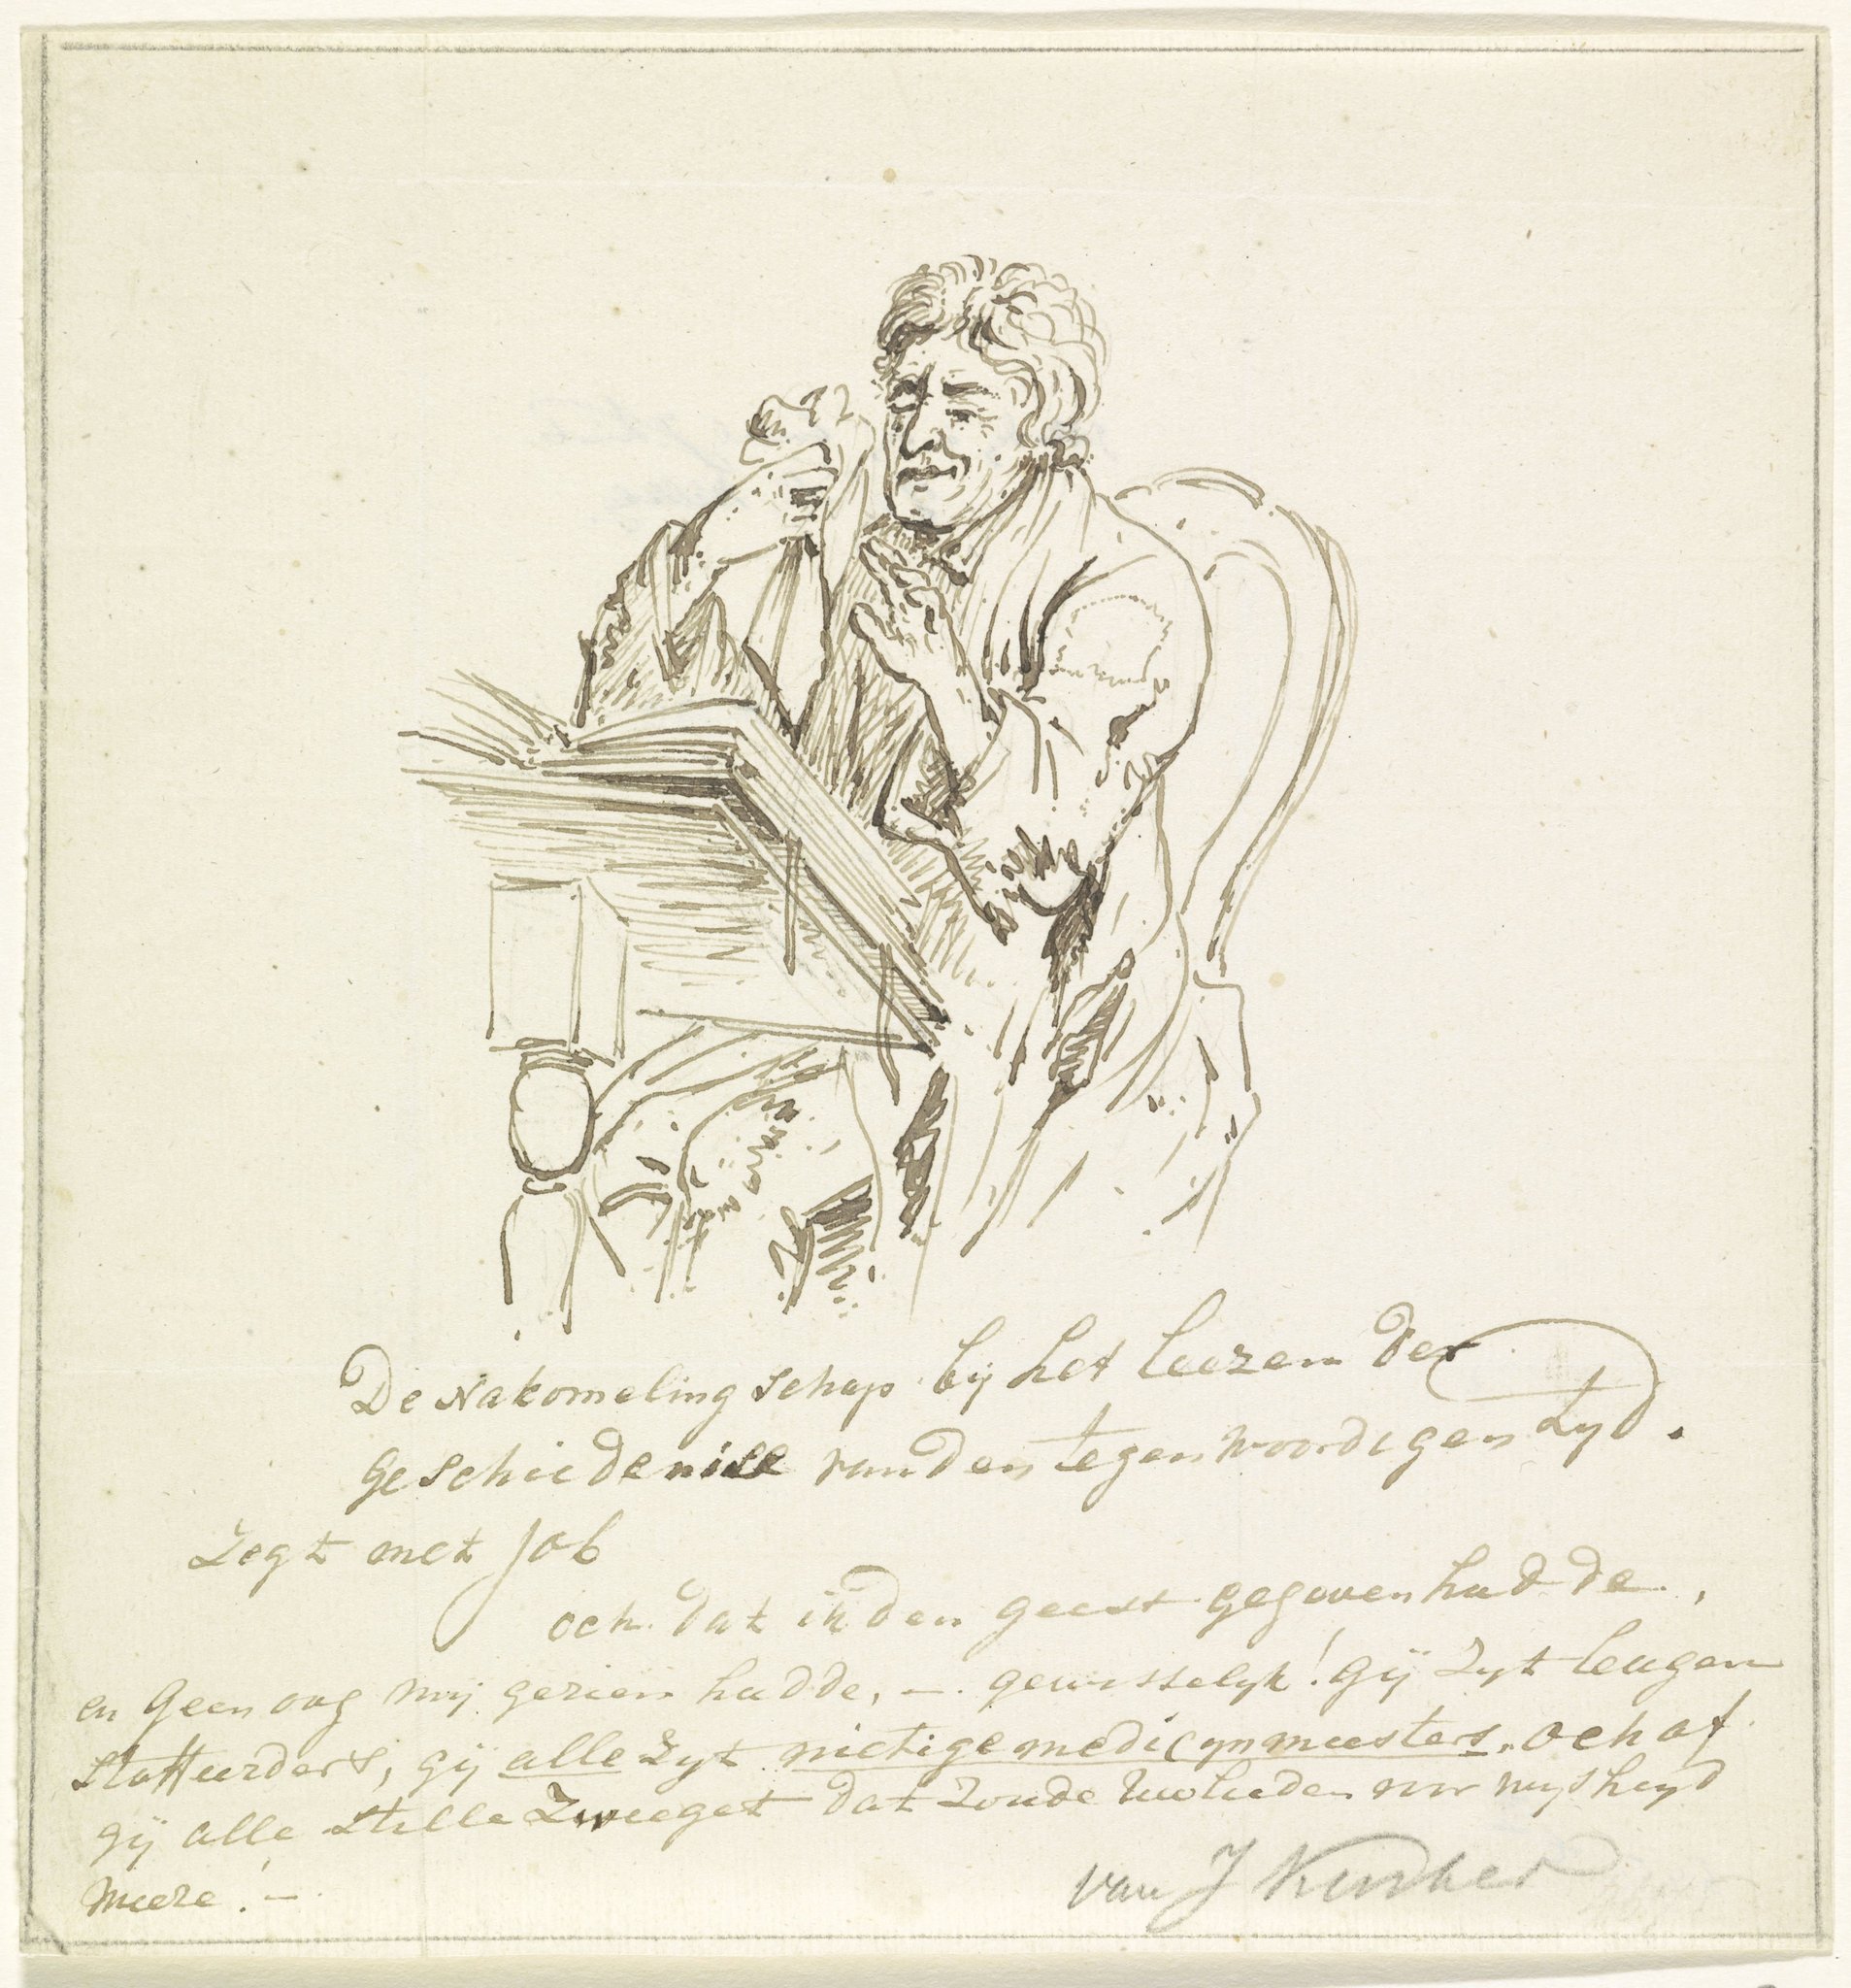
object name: drawing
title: Nakomeling lezend over de historie van de tegenwoordige tijd, 1796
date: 1795-1845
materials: paper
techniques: pen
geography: netherlands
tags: reading, heraclitus, the weeping philosopher, and democritus, the laughing philosopher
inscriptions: collector's mark: Lugt 2228, inscription: ‘gevonden in den boedel J. Kinker / of J.M. Willemsz.’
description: Spotprent van een man (onze nakomeling) die bij het lezen van de historie van de tegenwoordige tijd zowel moet huilen als lachen, 1796. Met handgeschreven onderschrift van acht regels.